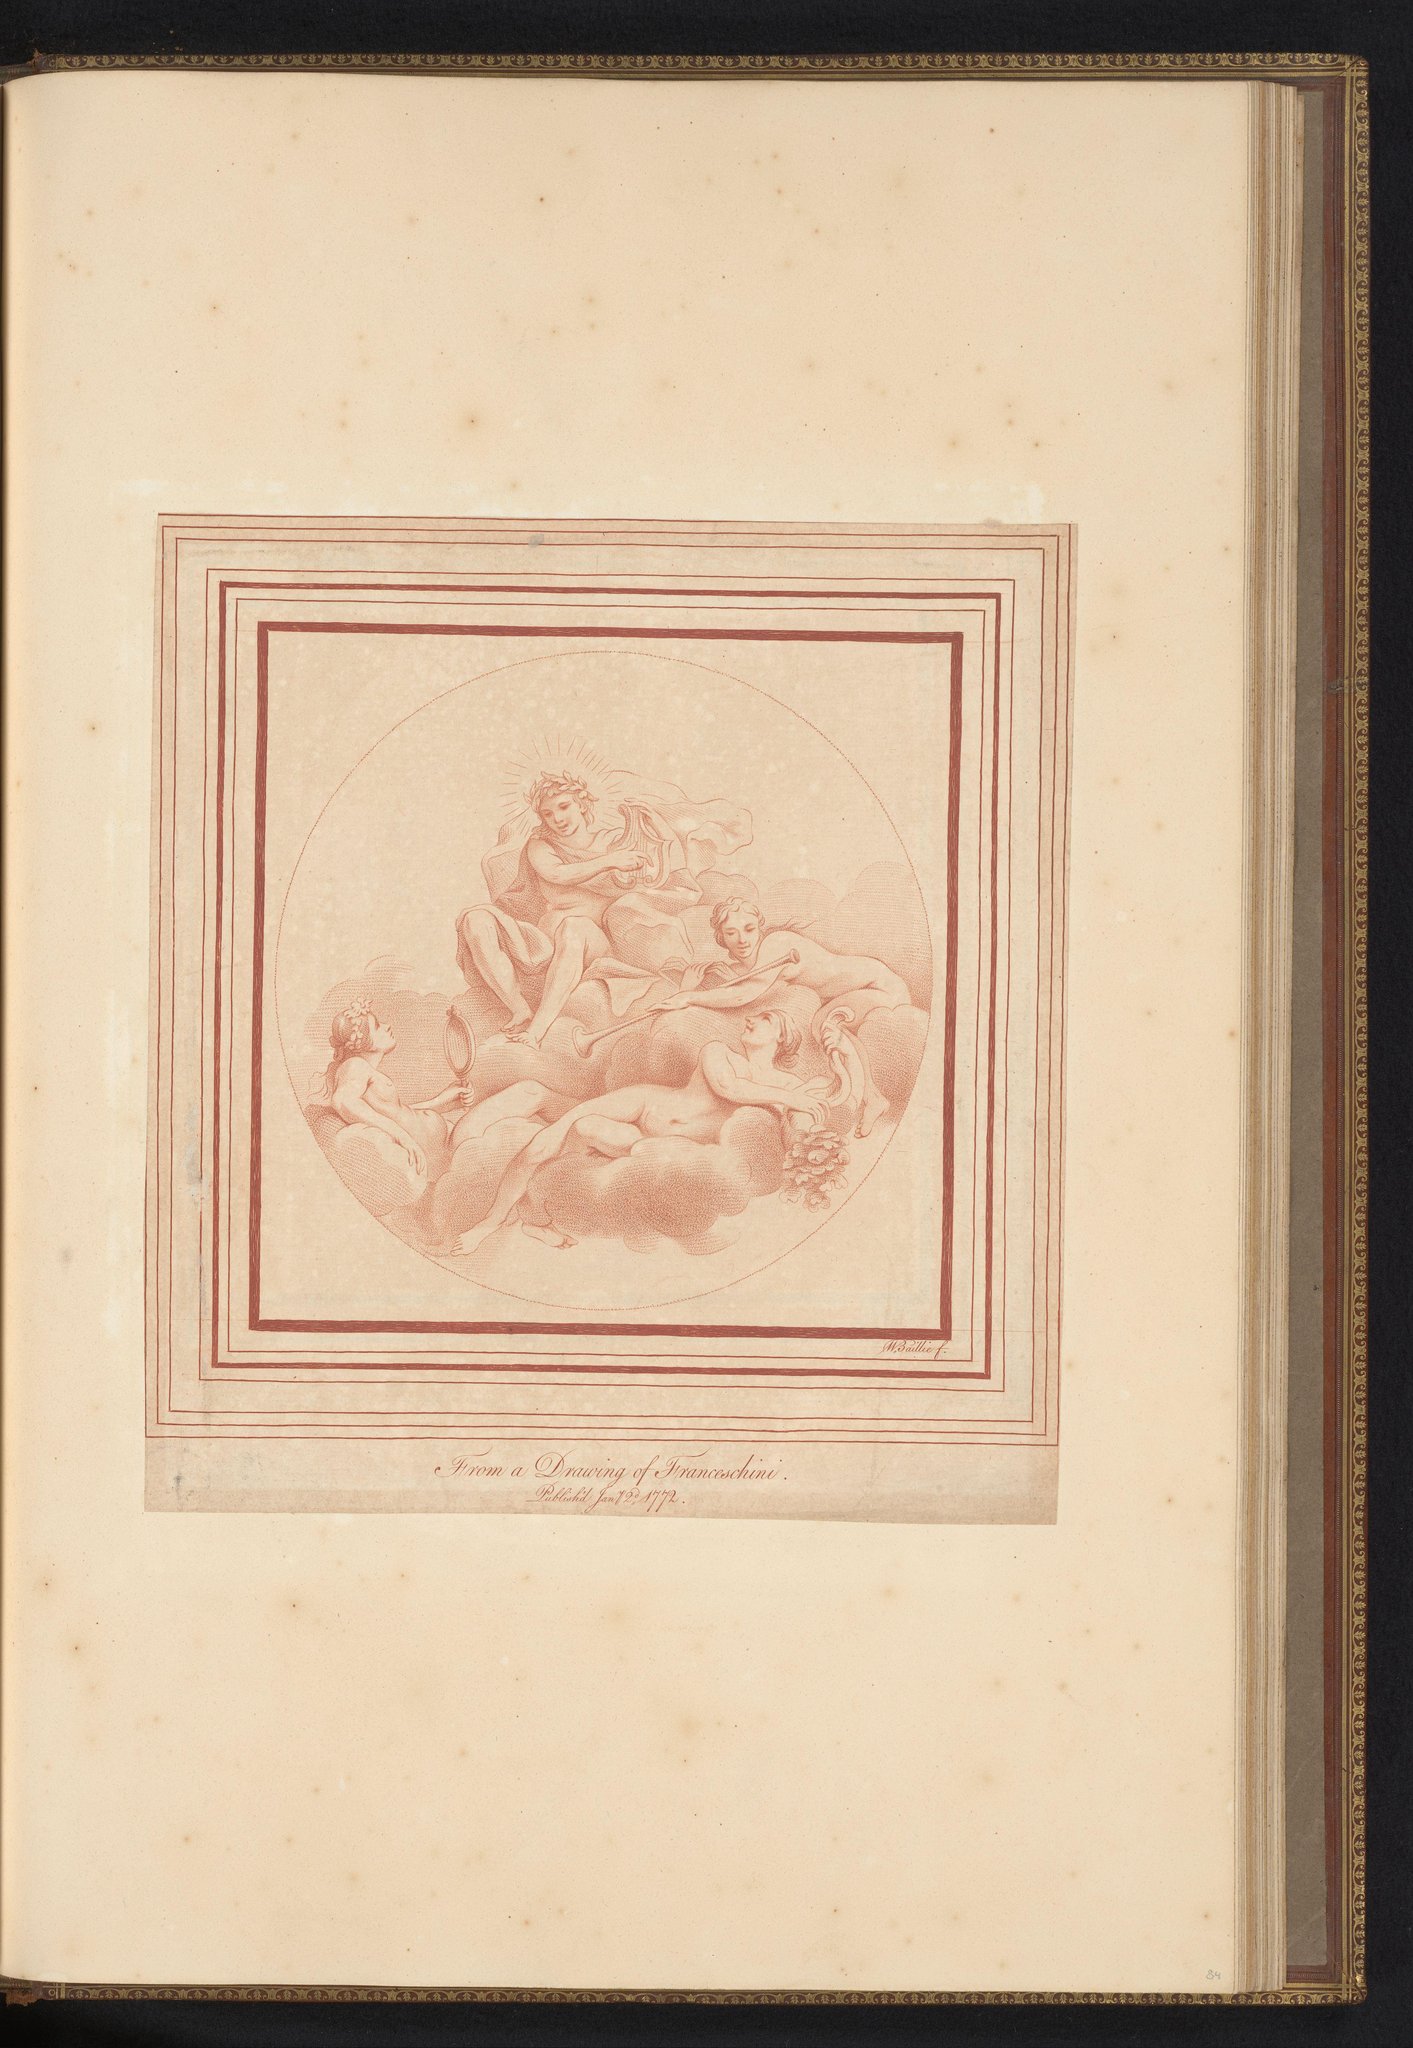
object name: print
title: Apollo en drie muzen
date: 1772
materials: paper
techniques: printmaking, etching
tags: (story of) apollo (phoebus), (story of the) muses; 'muse' (ripa)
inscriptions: date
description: Apollo zitten in de wolken met zijn lier. Om hem heen drie muzen met een spiegel, trompet en hoorn des overvloeds. De prent maakt deel uit van een album.